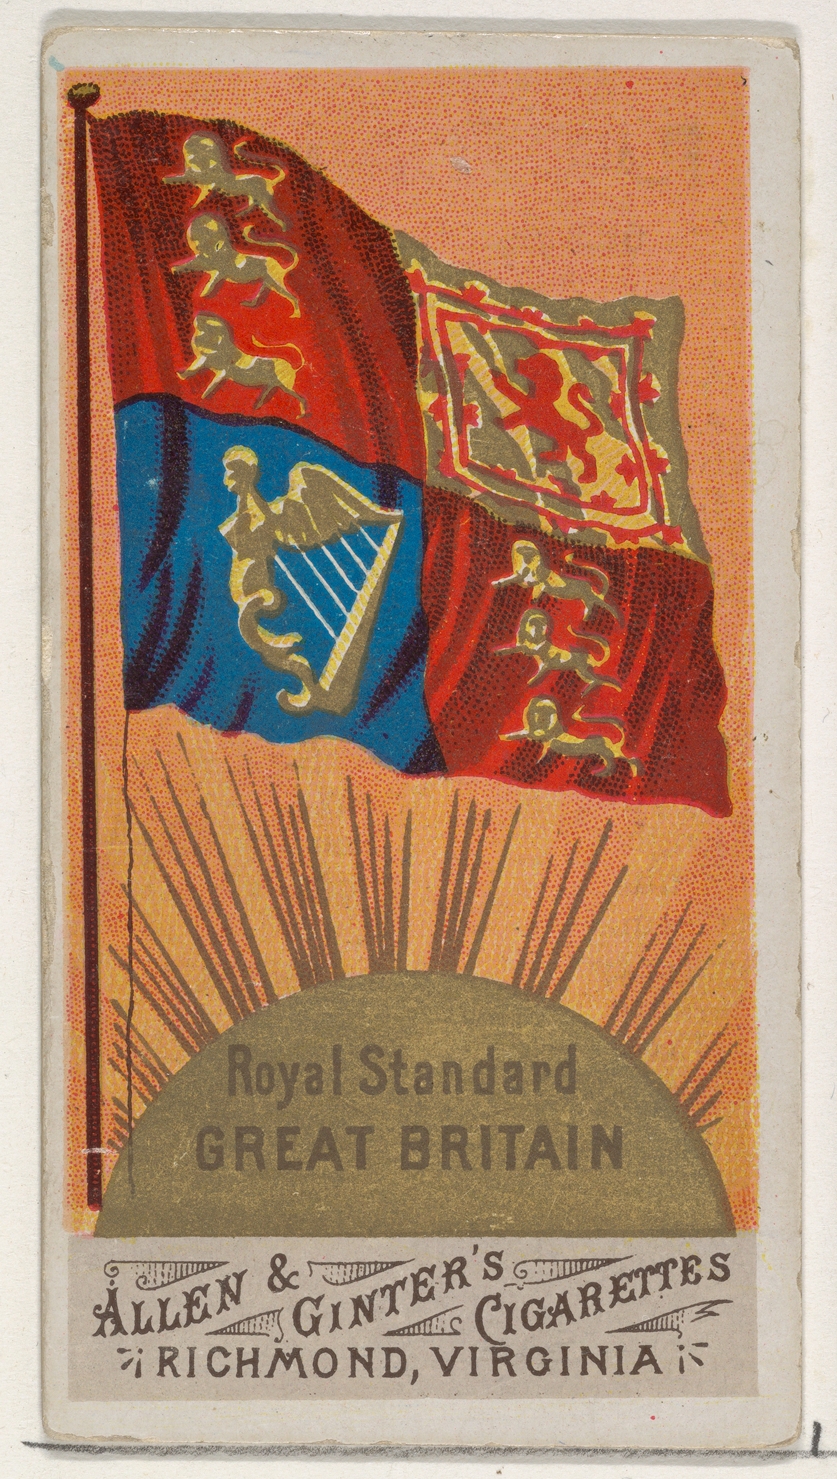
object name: print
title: Royal Standard, Great Britain, from Flags of All Nations, Series 1 (N9) for Allen & Ginter Cigarettes Brands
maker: allen & ginter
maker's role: publisher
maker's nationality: american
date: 1887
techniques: color lithograph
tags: flags